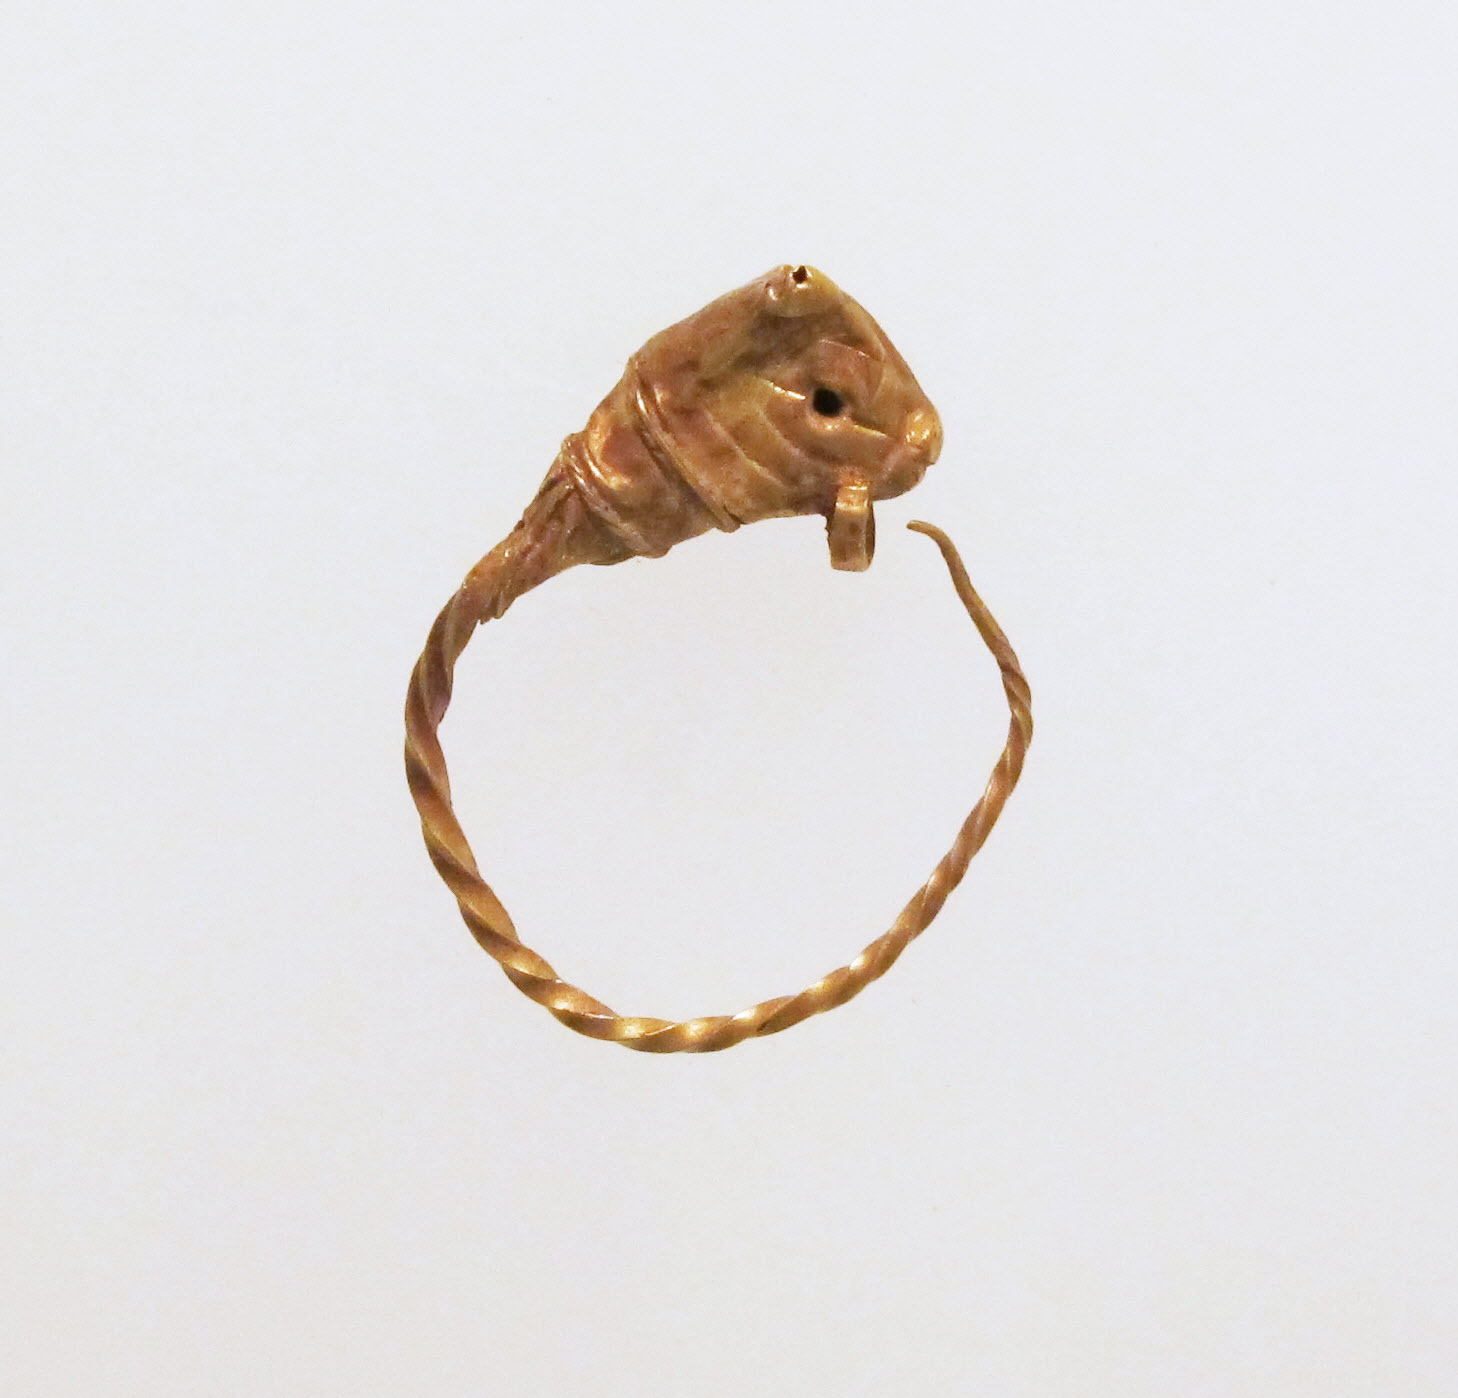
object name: earring with head of bull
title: Gold earring with head of a bull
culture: greek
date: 400-201 BCE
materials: gold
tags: bulls